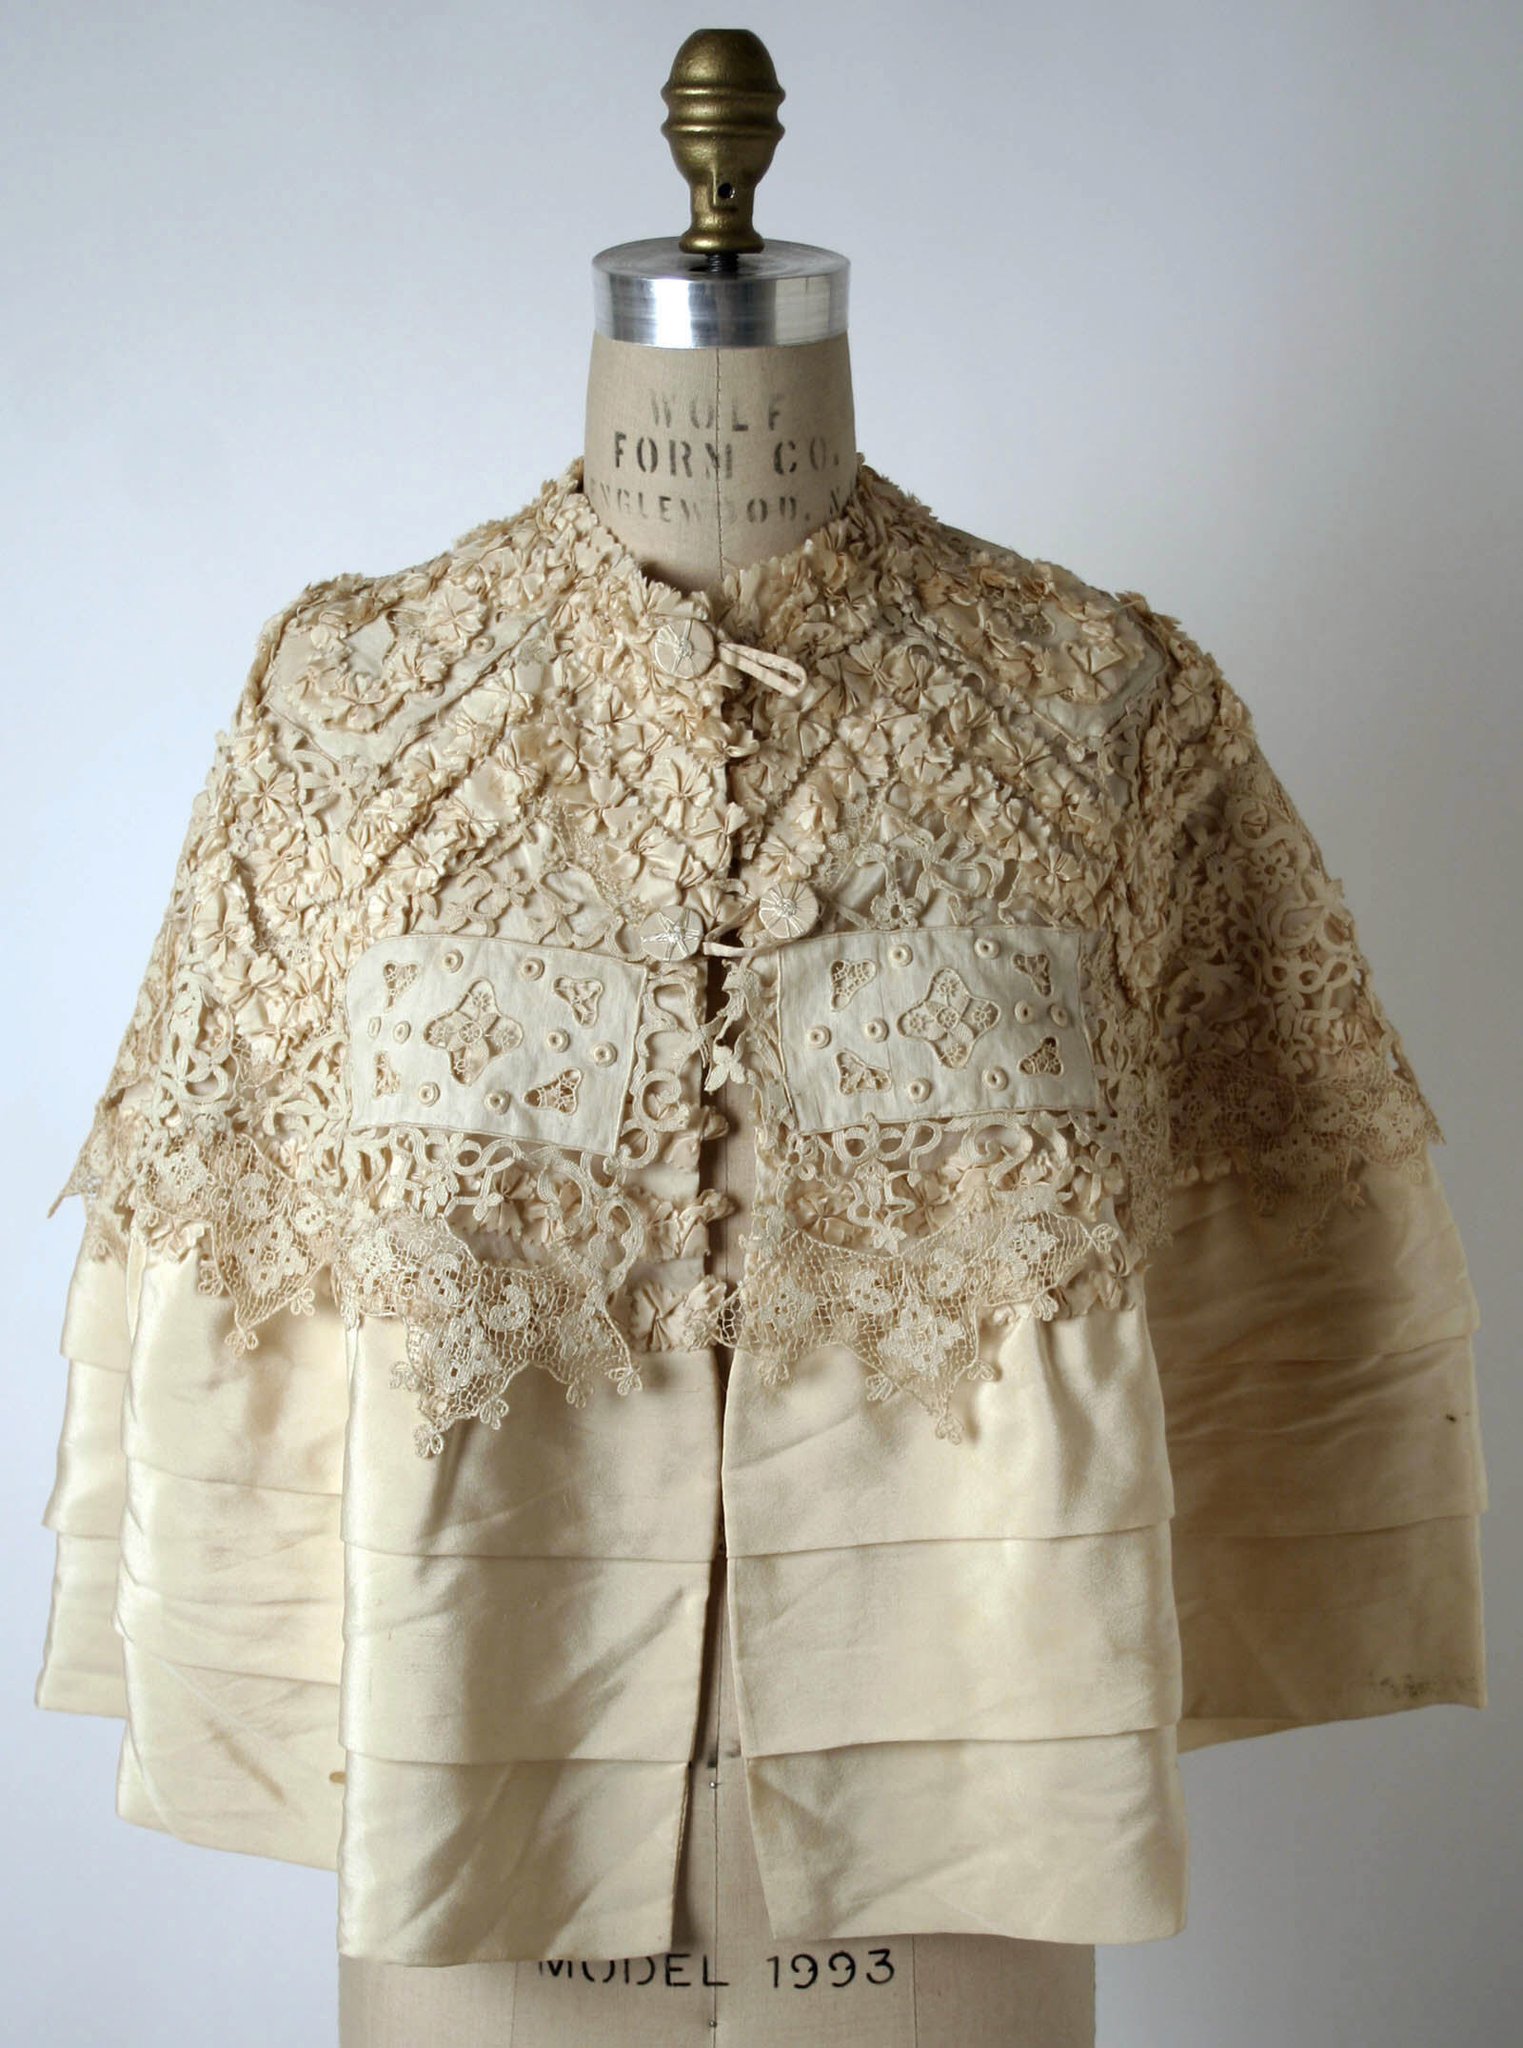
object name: cape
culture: french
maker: house of paquin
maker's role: design house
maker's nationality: french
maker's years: 1891-1956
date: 1900-1909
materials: silk